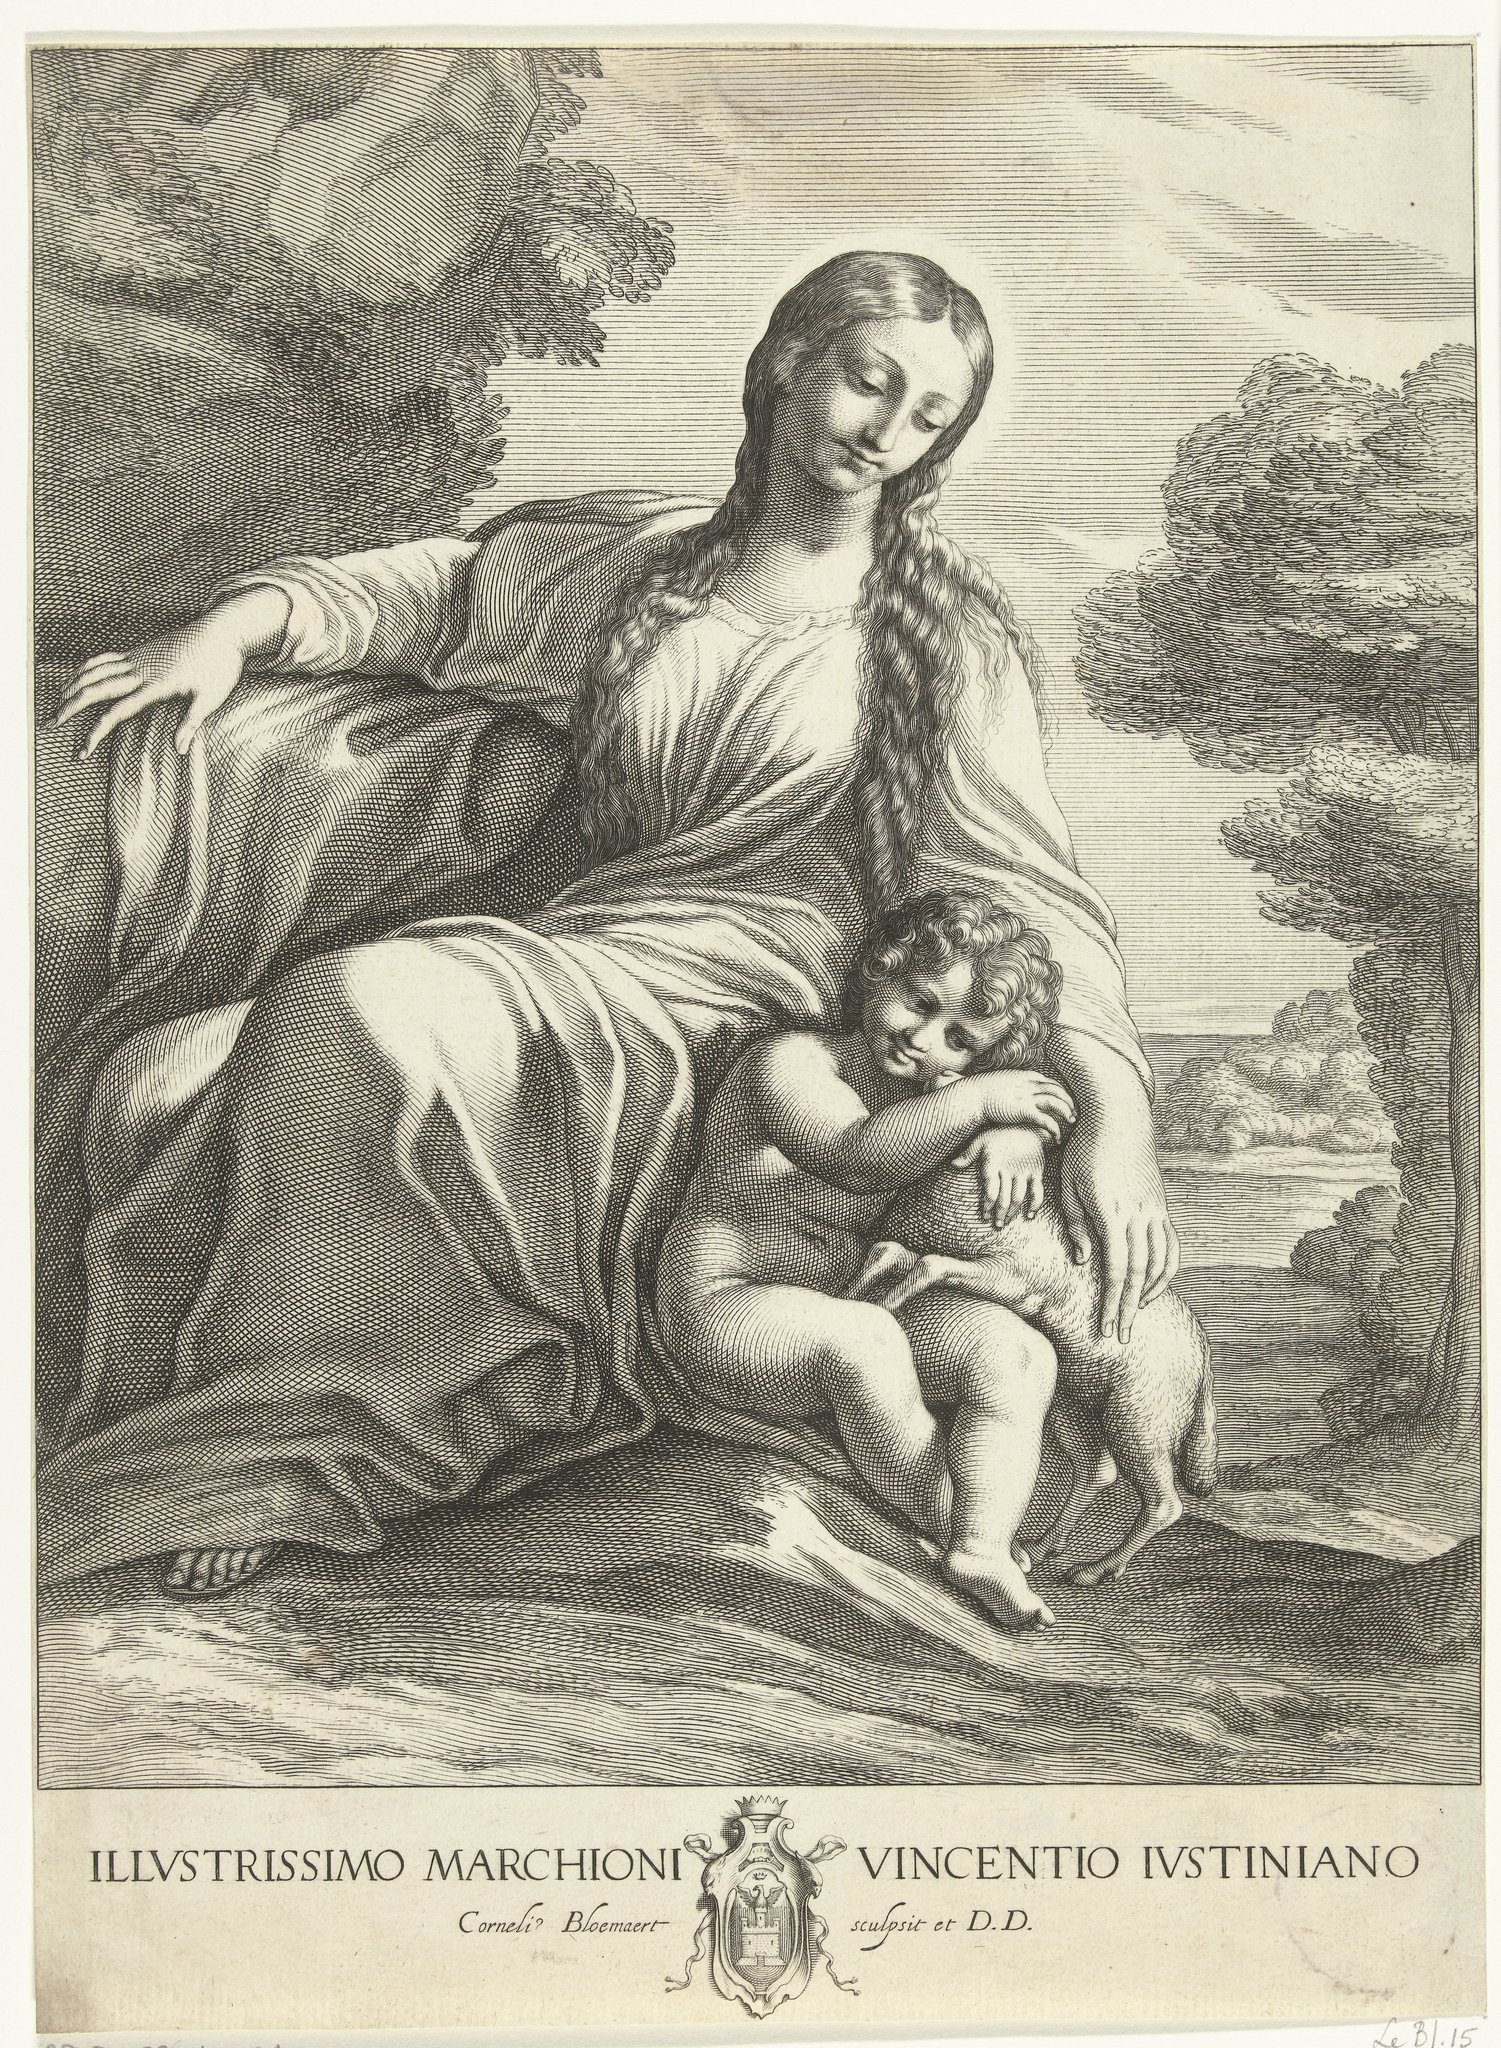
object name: print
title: Zittende Madonna met lam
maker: cornelis bloemaert (ii)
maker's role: draughtsman, print maker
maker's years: 1603-1692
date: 1633-1638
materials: paper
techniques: engraving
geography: rome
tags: christ-child playing with lamb ~ madonna-representations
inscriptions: collector's mark: Lugt 240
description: Op een grasveld tussen bomen zit Maria, haar linkerarm losjes om het Christuskind geslagen dat liefdevol een lammetje omarmt.